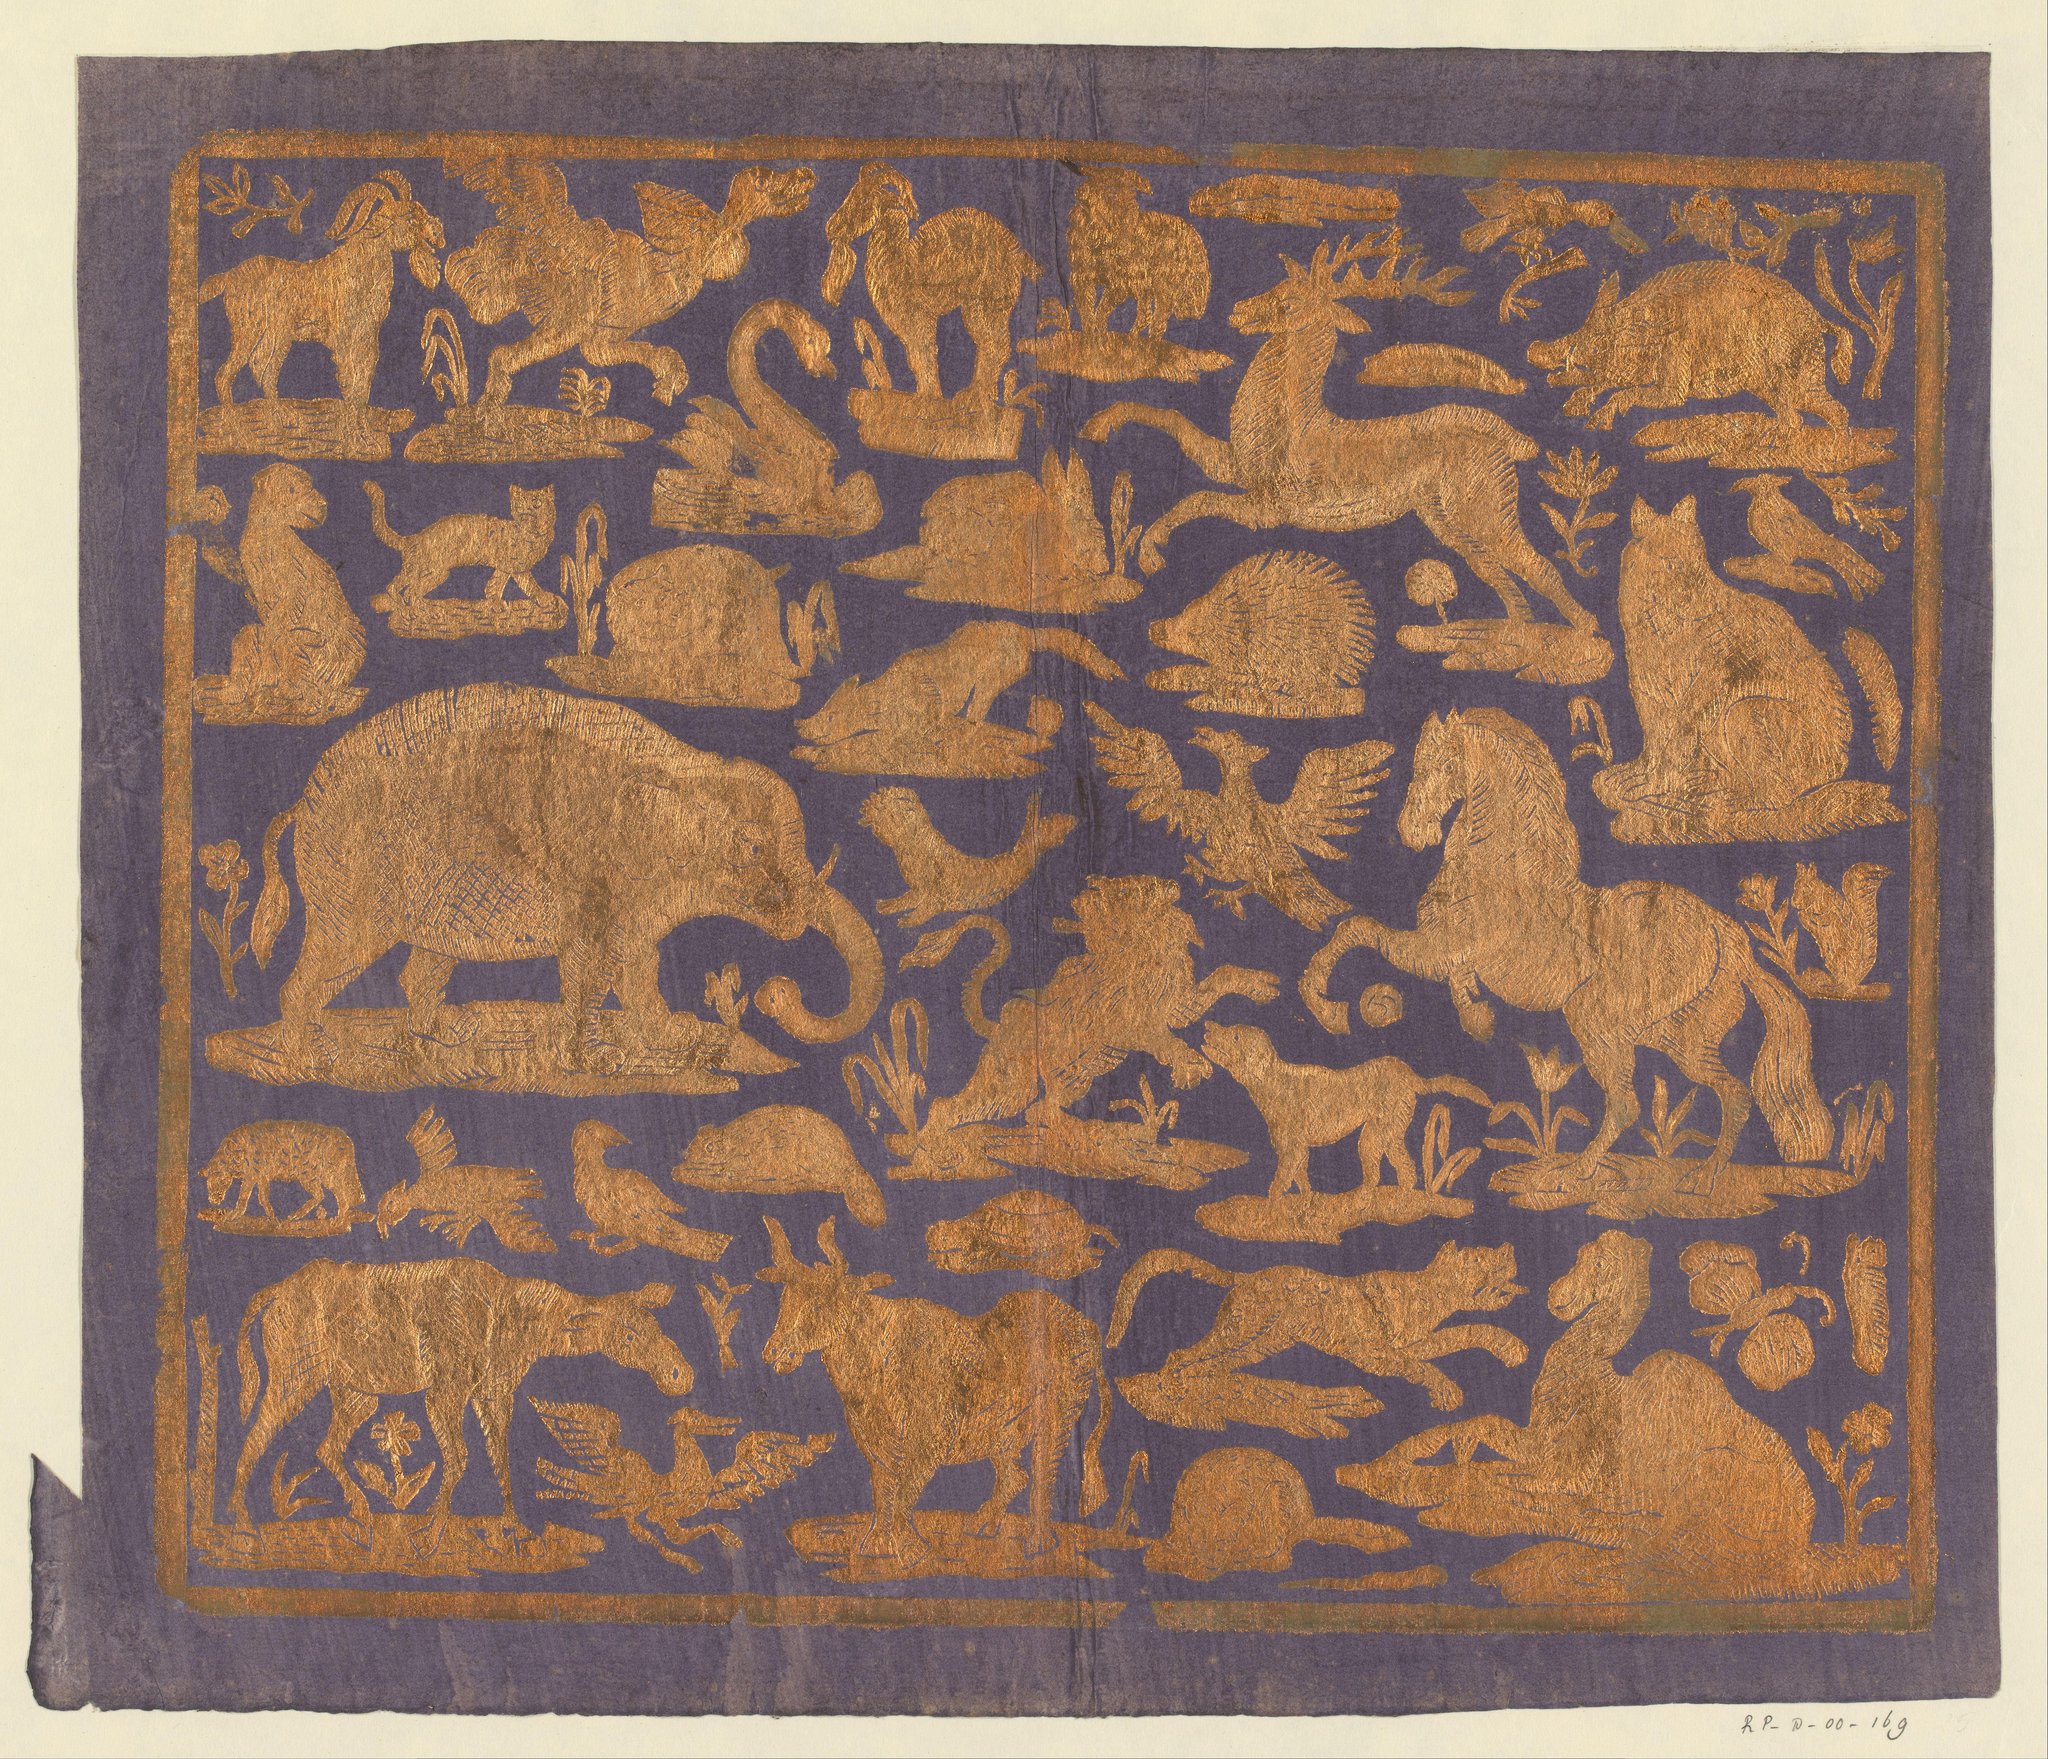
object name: brocade paper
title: Blad met dieren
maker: Anonymous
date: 1750-1800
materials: gold leaf, paint, paper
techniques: relief print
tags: animals, cattle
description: Blad met dieren; linksboven bok, rechtsboven wild zwijn, linksonder ezel, rechtsonder dromedaris.